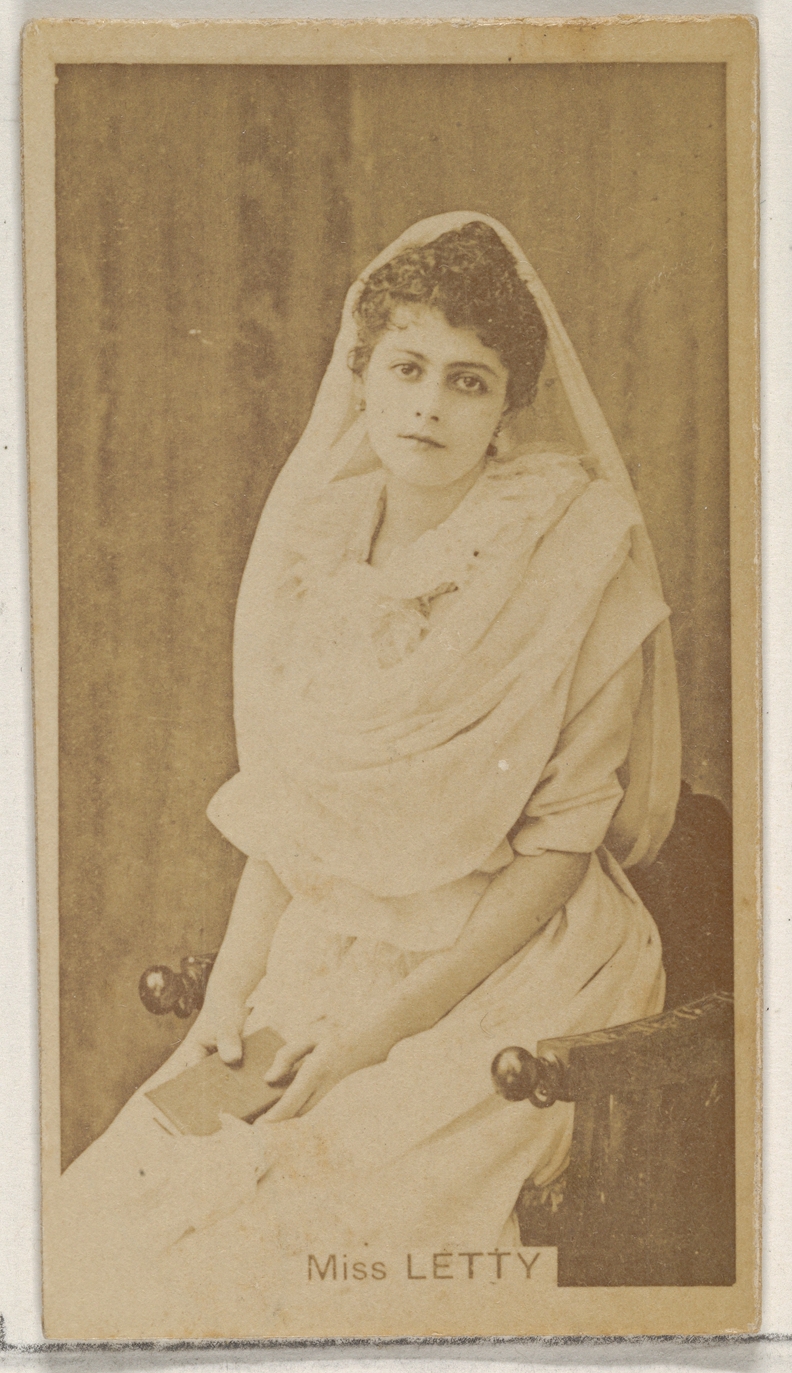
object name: photograph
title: Miss Letty, from the Actors and Actresses series (N45, Type 8) for Virginia Brights Cigarettes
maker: allen & ginter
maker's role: publisher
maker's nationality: american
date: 1888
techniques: albumen silver print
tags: portraits,women,actresses